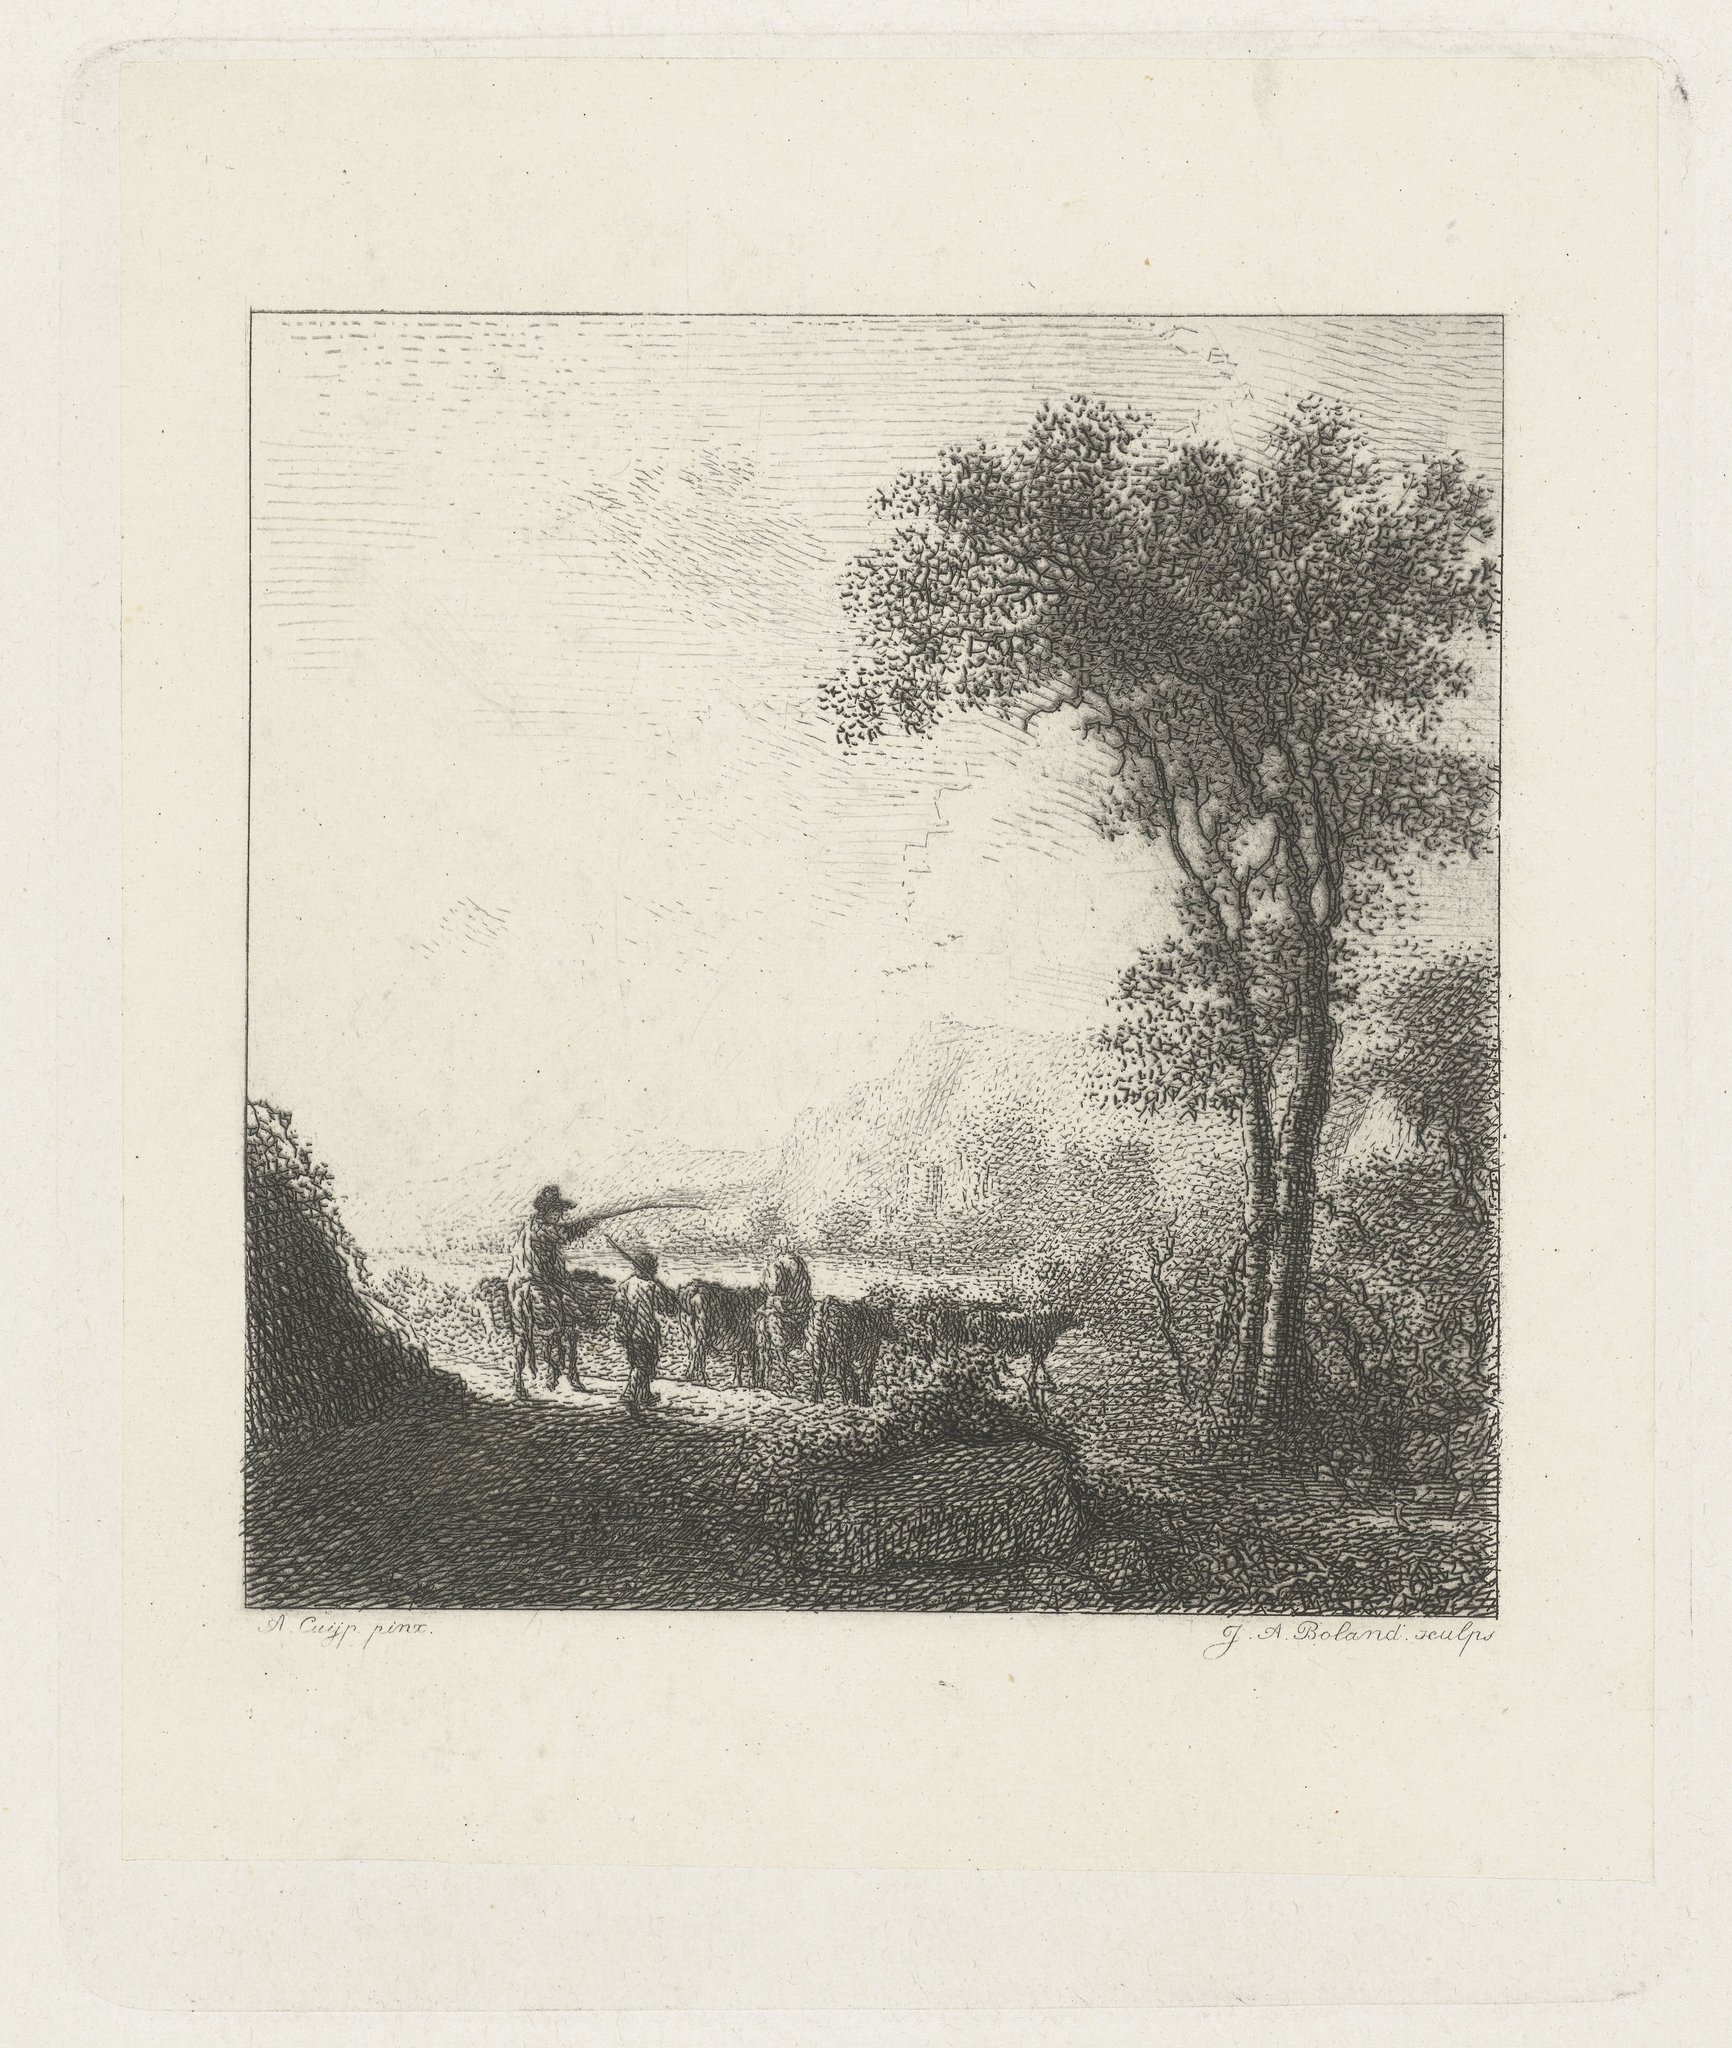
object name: print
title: Landschap met herders en vee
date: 1875-1876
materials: paper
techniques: etching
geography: amsterdam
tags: pastorals, arcadian scenes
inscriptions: collector's mark: Lugt 2228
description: Reproductie van een schilderij uit de collectie van het Rijksmuseum Amsterdam, SK-A-78. Prent afkomstig uit: Brink, J. ten (et al.). Het Rijksmuseum te Amsterdam: [25] etsen van J.A. Boland. Haarlem: J.M. Schalekamp, [1875-1876] (13 A 20).